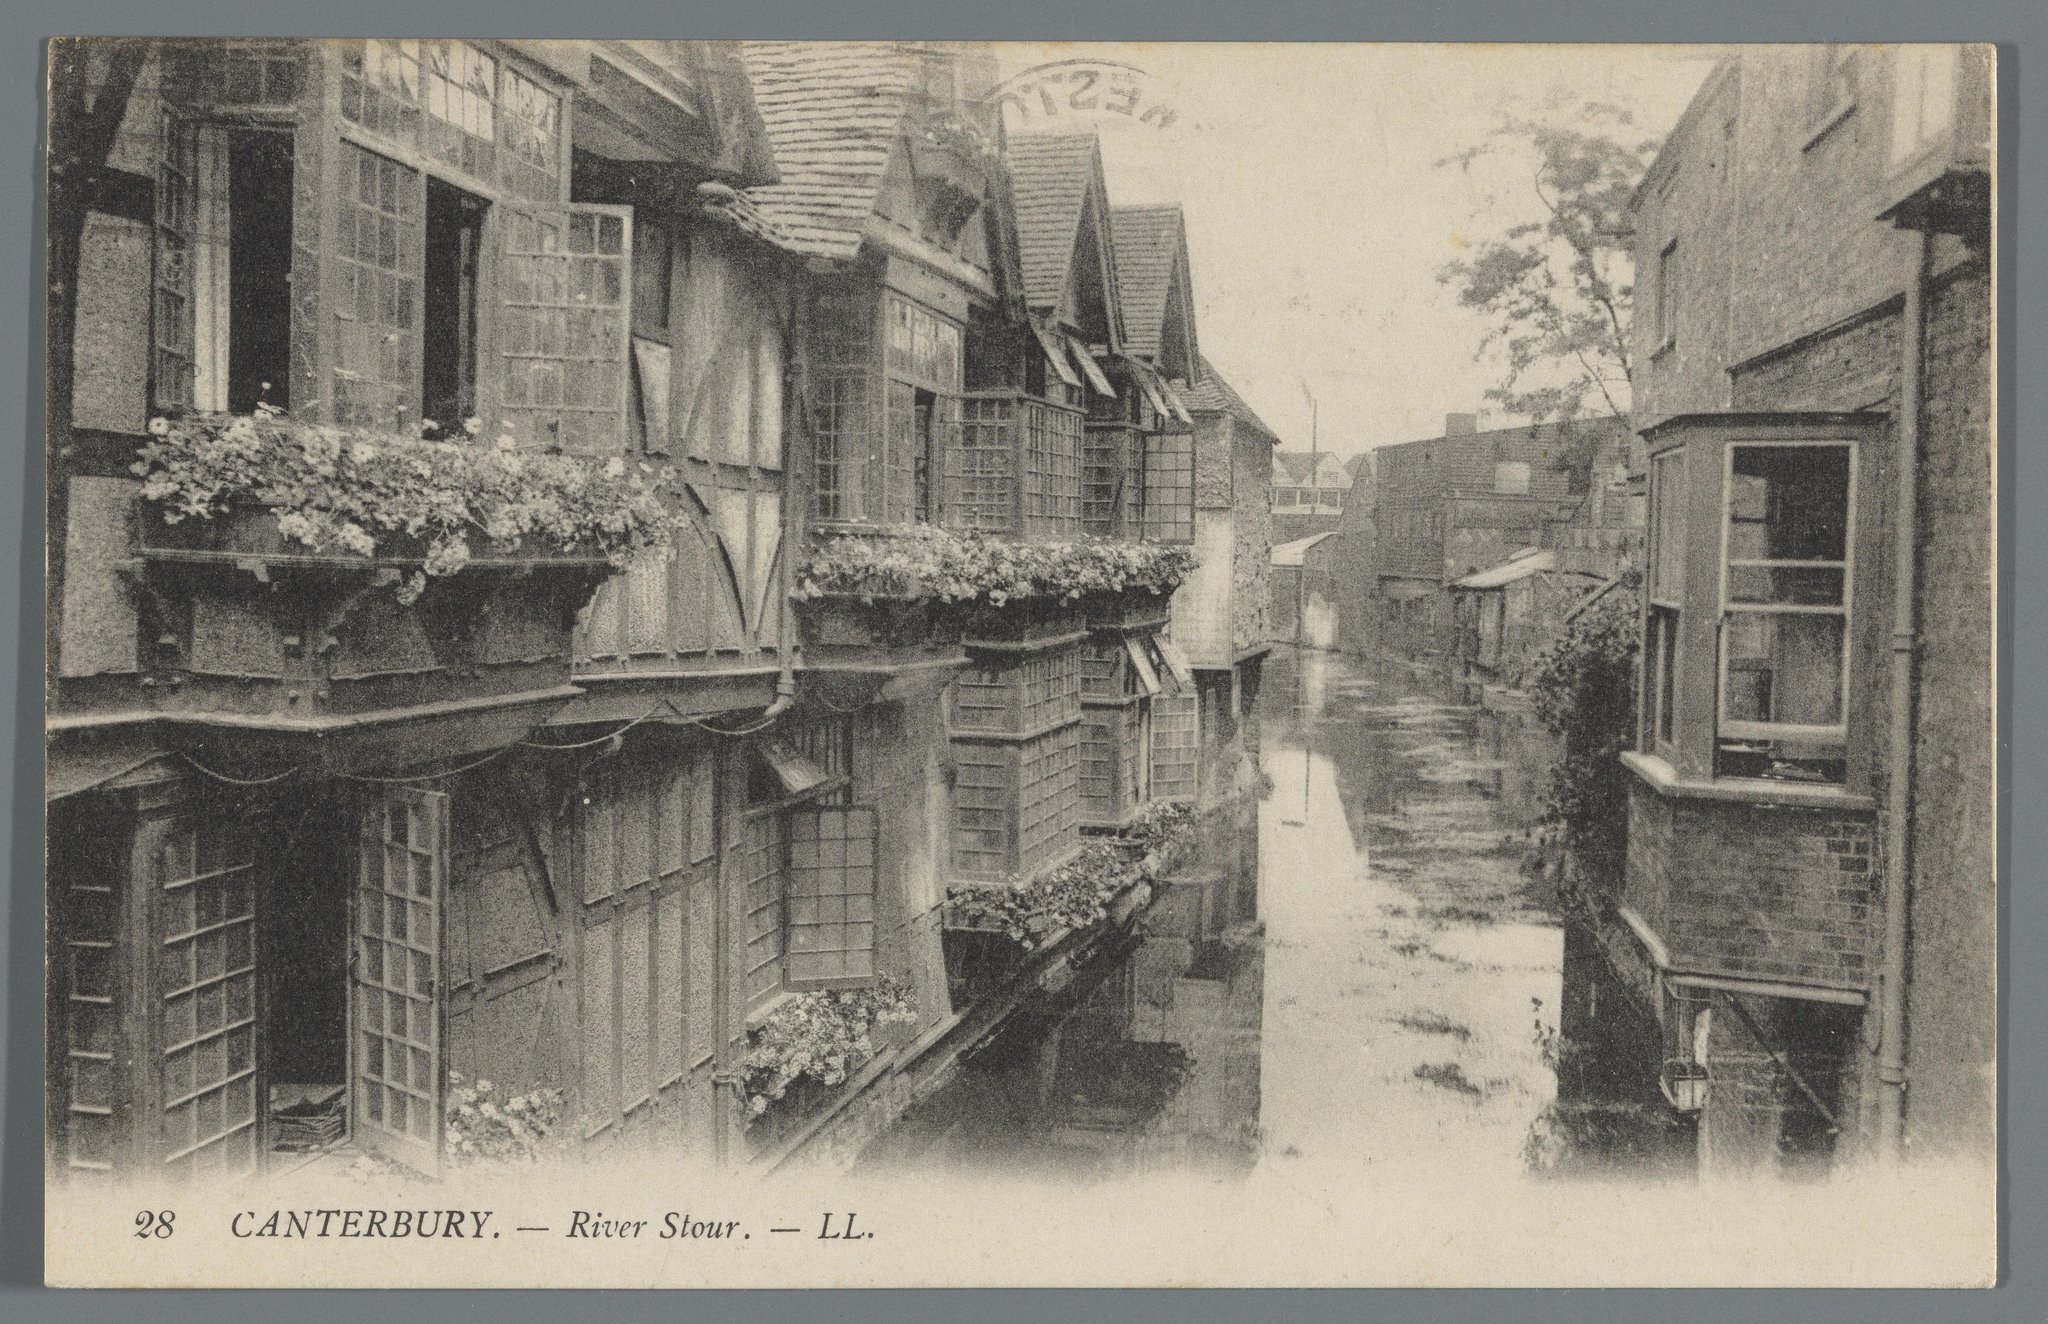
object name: postcard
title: Canterbury, River stour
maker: Anonymous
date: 1920-1950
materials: photographic support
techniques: photograph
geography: canterbury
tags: canterbury